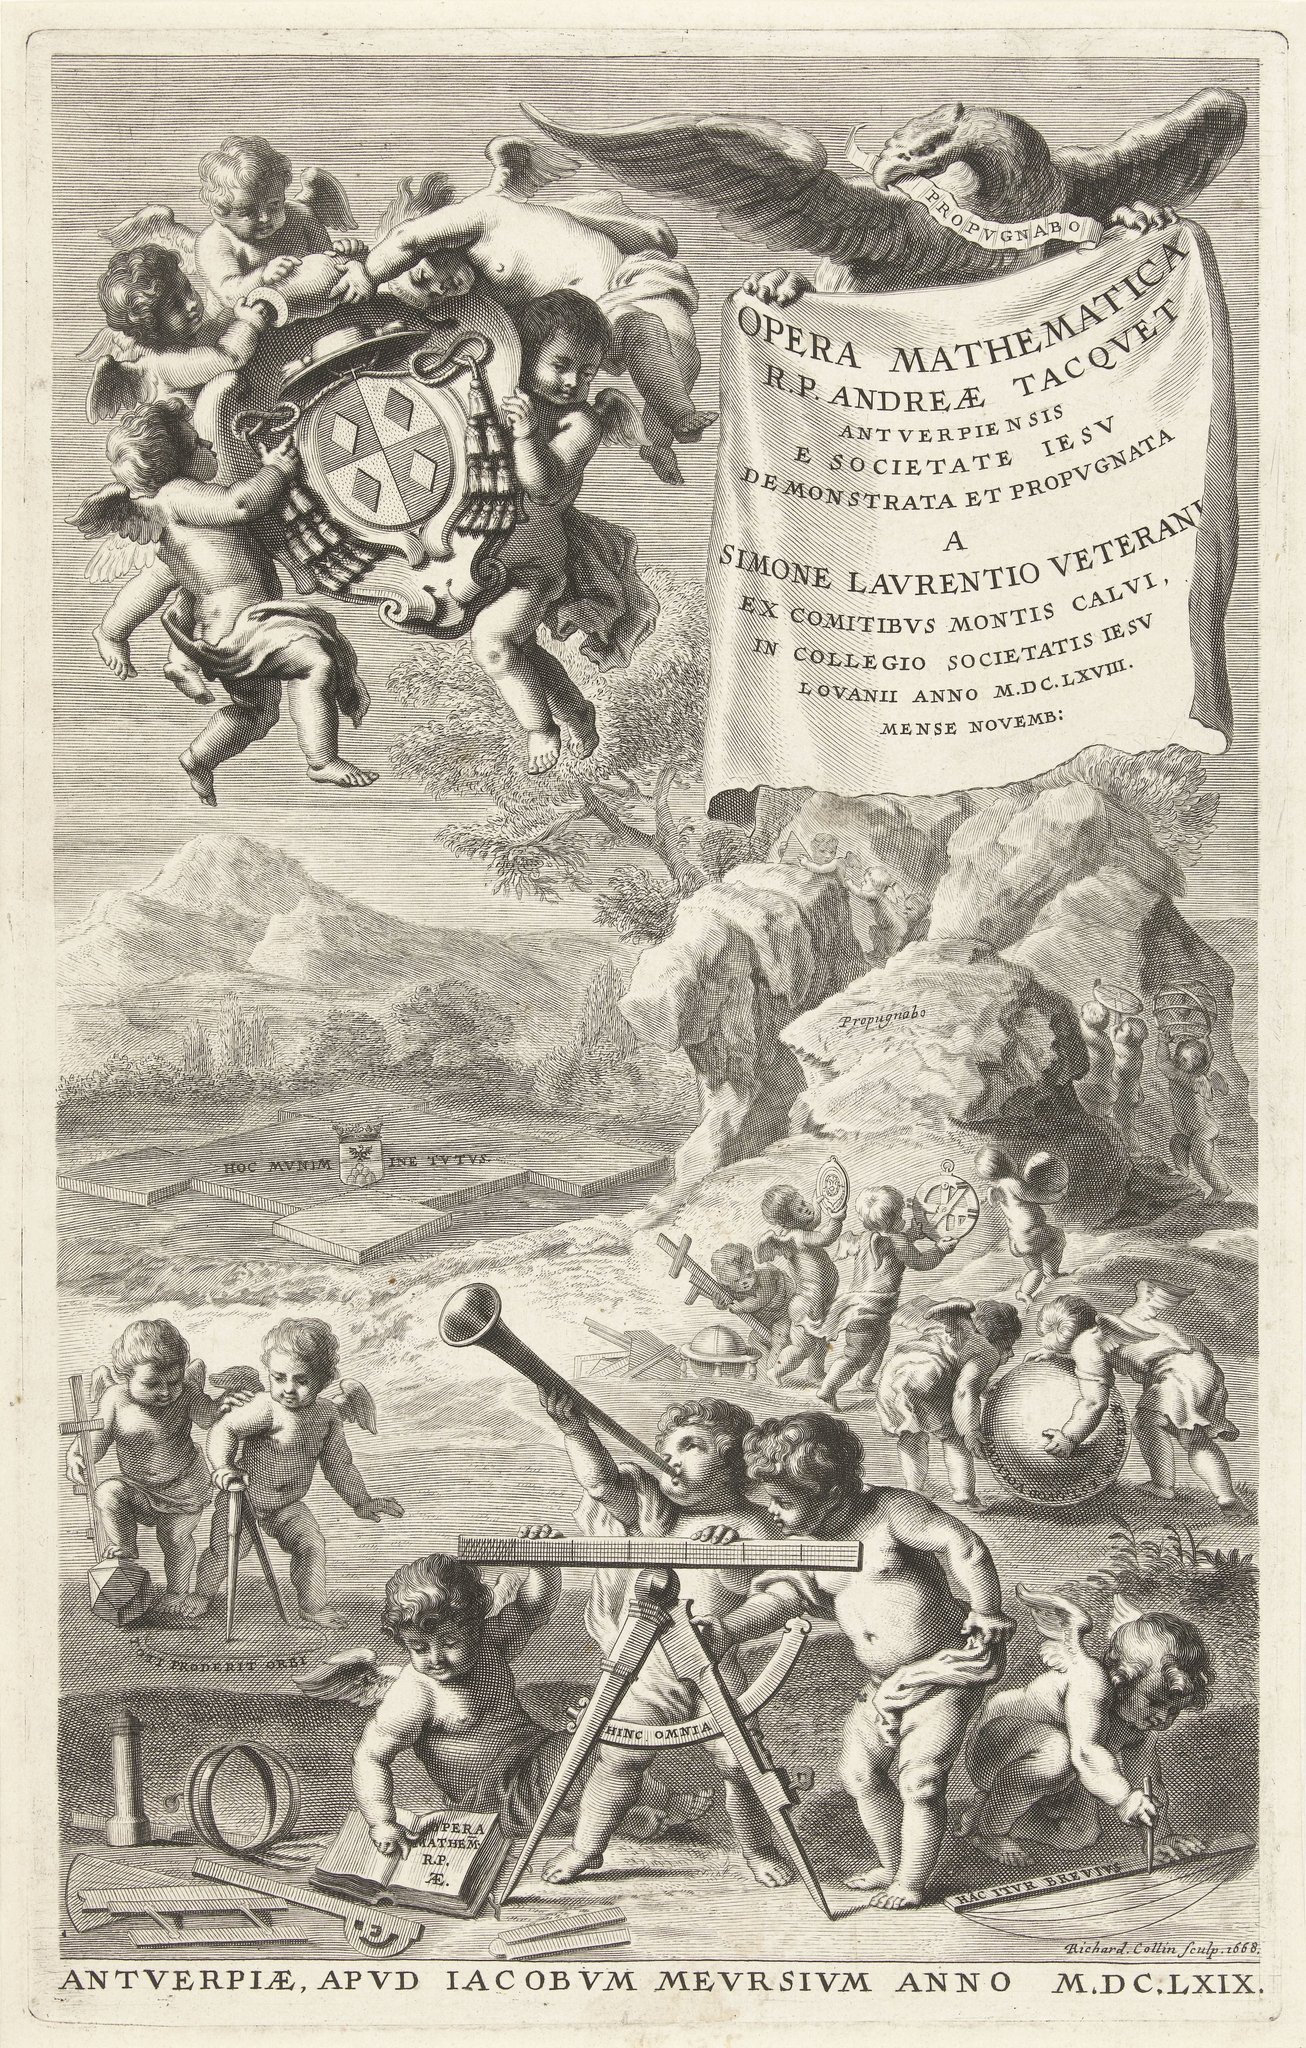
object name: print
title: Titelpagina voor: André Tacquet, Opera mathematica, 1669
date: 1668-1669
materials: paper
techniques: engraving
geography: antwerp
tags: clemens ix, measuring-instruments, cupids: 'amores', 'amoretti', 'putti', calculating-instruments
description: Een groepje putti speelt buiten met mathematische instrumenten. Een aantal verstopt de instrumenten tussen rotsen. Links naast de rotsen een plattegrond van een vesting. Een adelaar houdt met zijn klauwen een doek op met de titel van het boek. Naast hem dragen putti het kardinaalswapen van de latere paus Clemens IX.